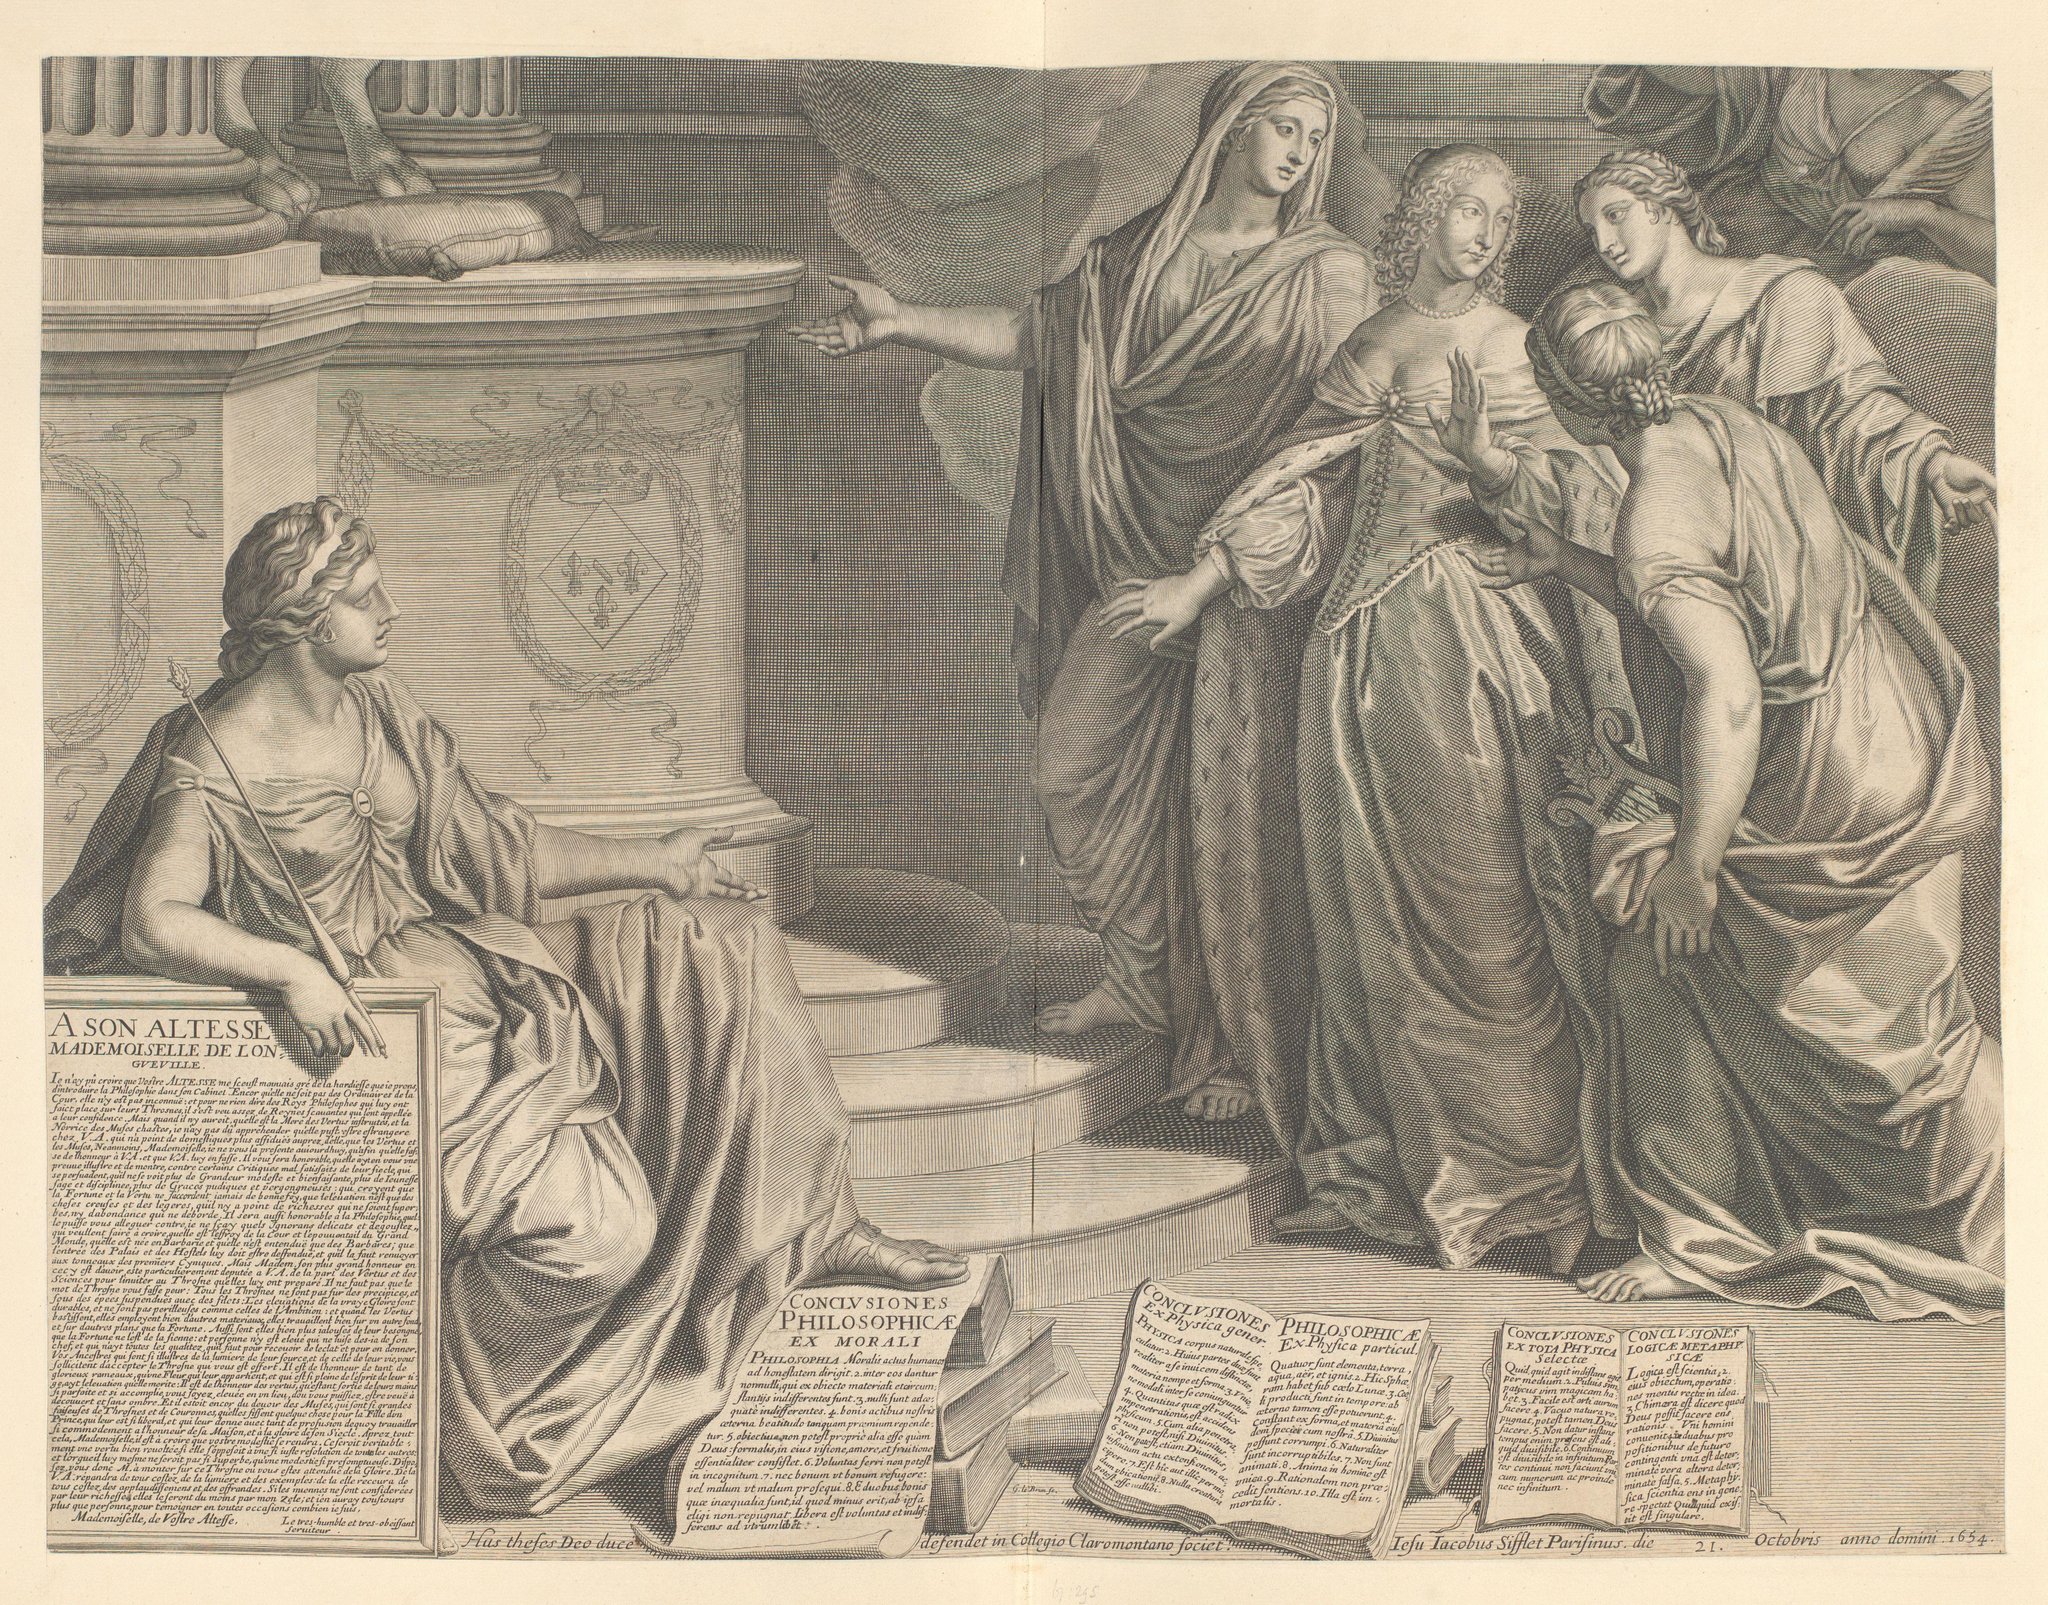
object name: album leaf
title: L'ouvrage de Charles le Brun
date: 1654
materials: paper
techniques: engraving, etching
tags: paris, anna genoveva van bourbon-condé, adult woman, historical persons - bb - woman, 'philosophia'; 'filosofia' (ripa)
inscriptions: date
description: Vrouwenfiguren leiden Anne Genoveva van Bourbon-Condé door een tempel. Deze prent maakt deel uit van een album.